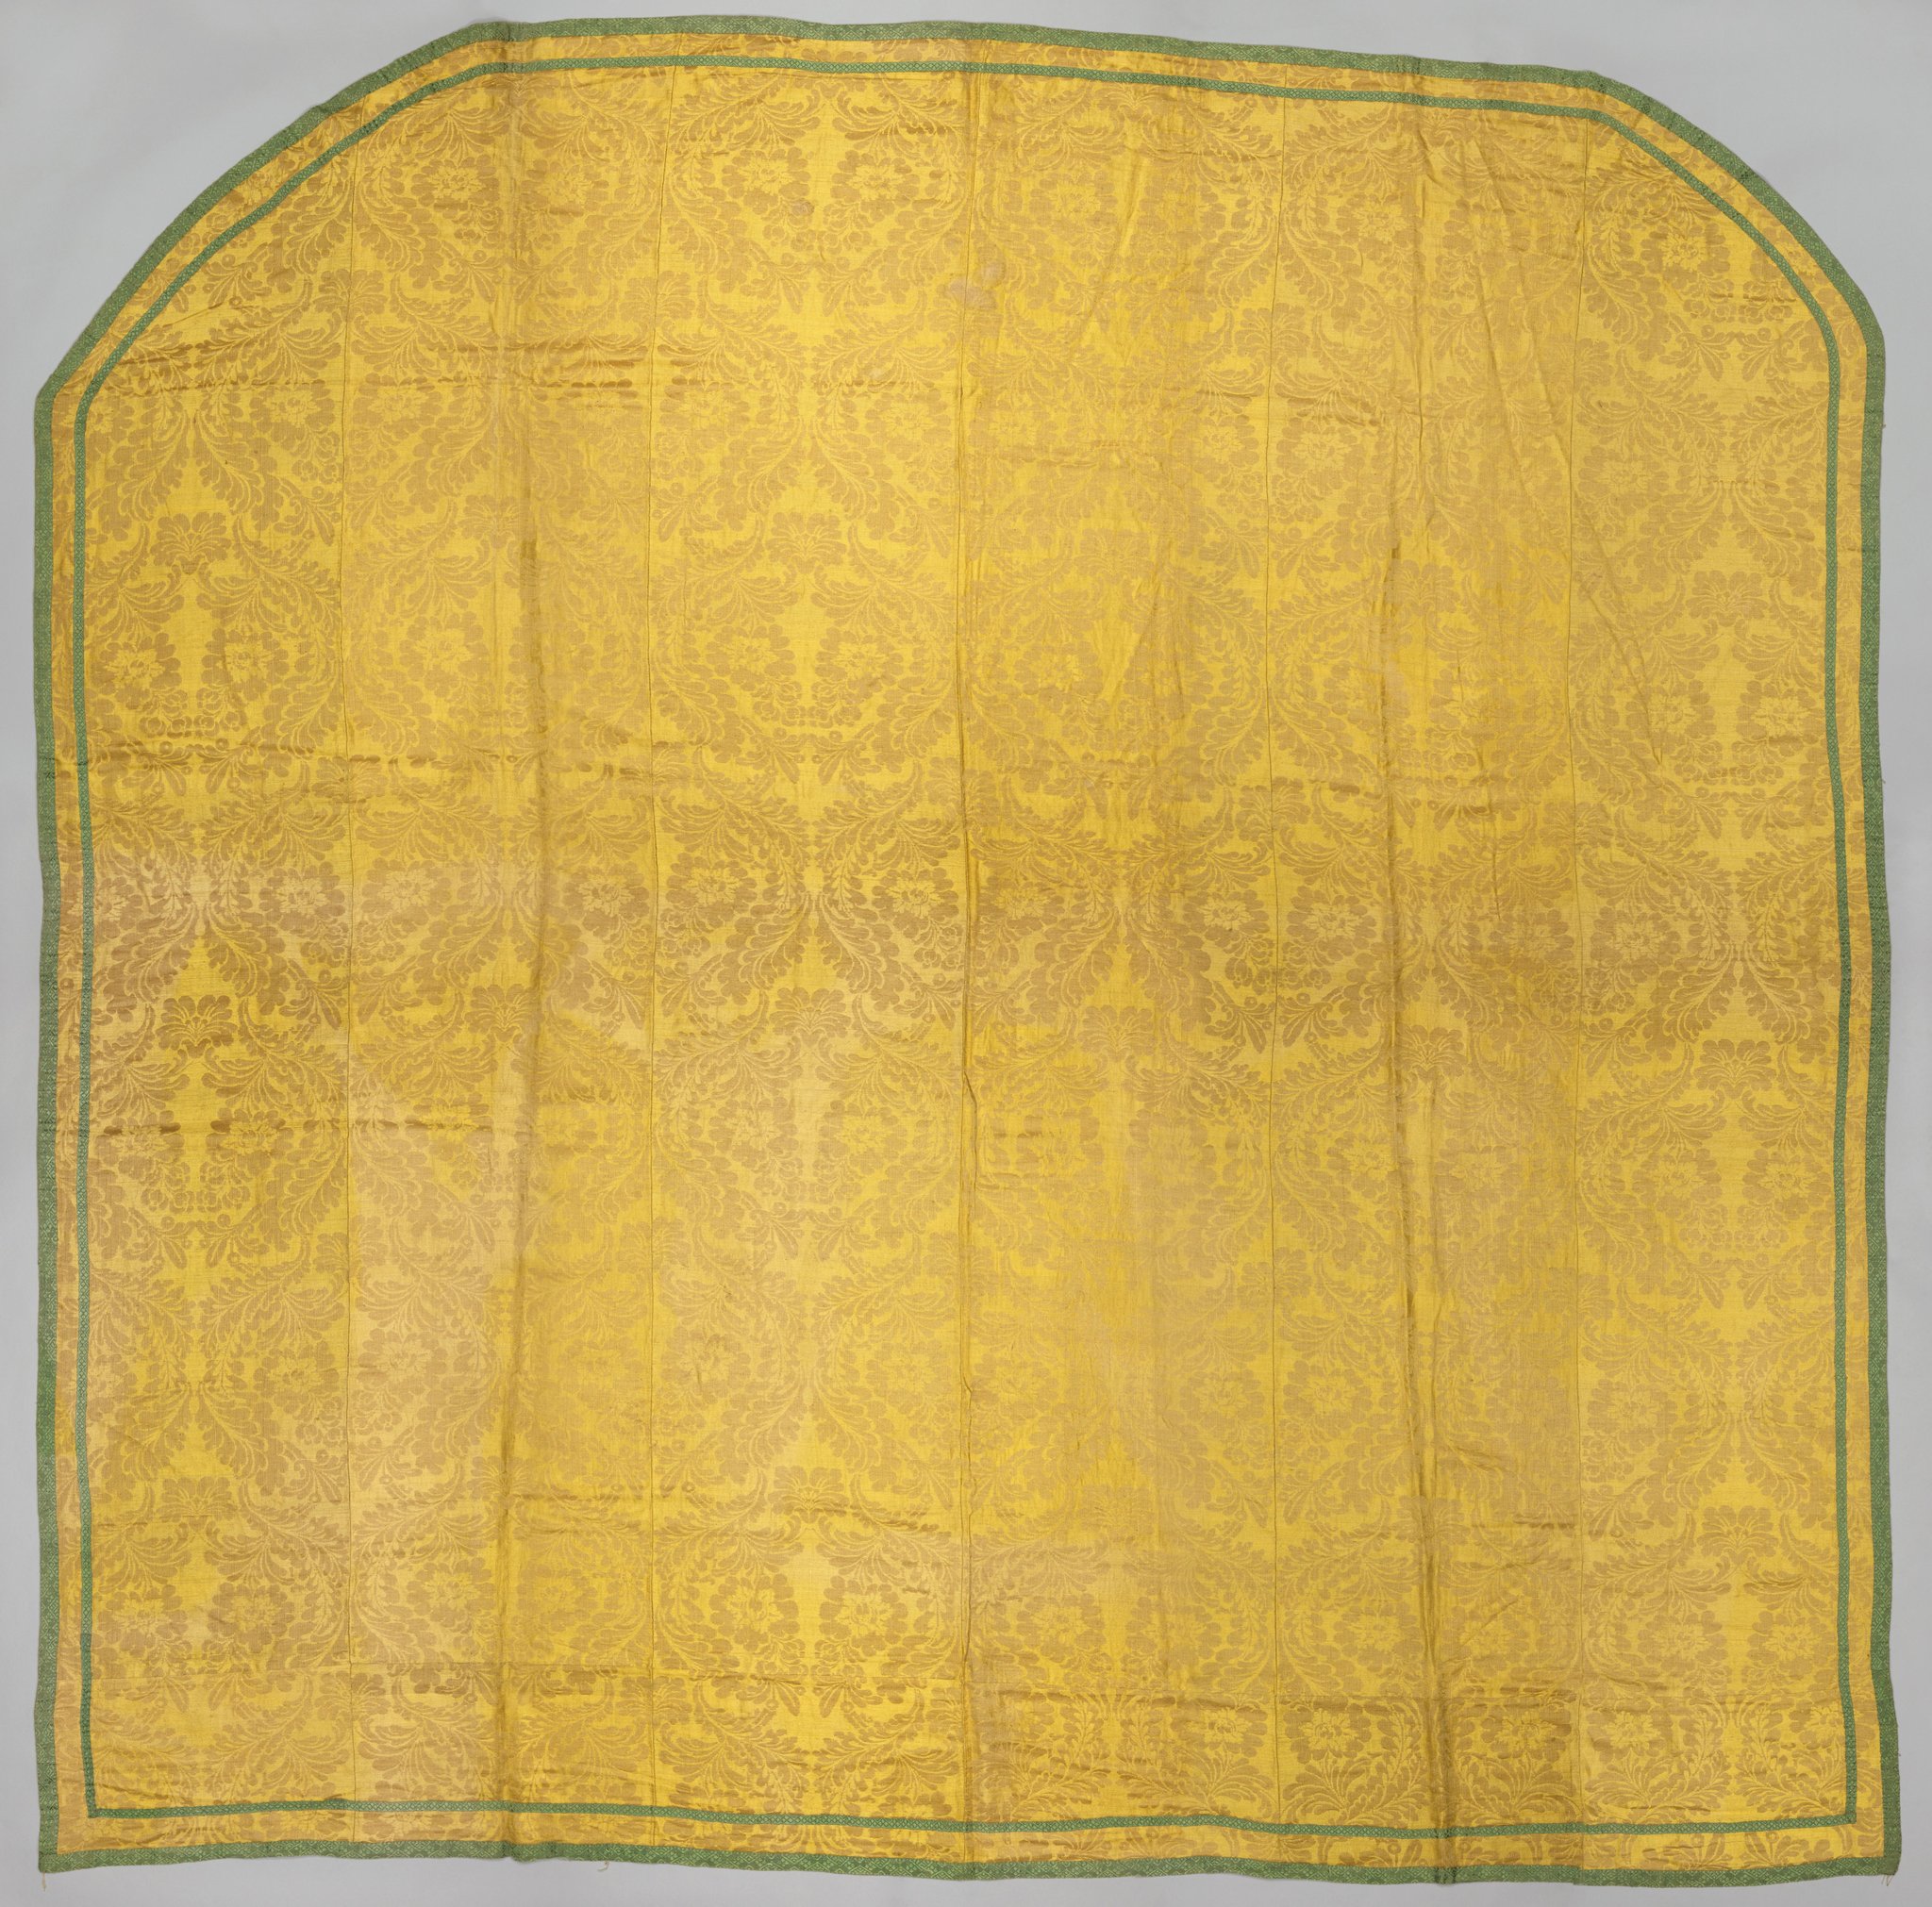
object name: bedspread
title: Sprei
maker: Anonymous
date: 1700-1750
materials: linen, silk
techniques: embroidered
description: Sprei van halfzijde weefsel met een geel damast-patroon van bloemen, afgewerkt met een groen zijden passement. Twee hoeken zijn afgerond. De sprei is gevoerd met ongebleekt linnen (?).